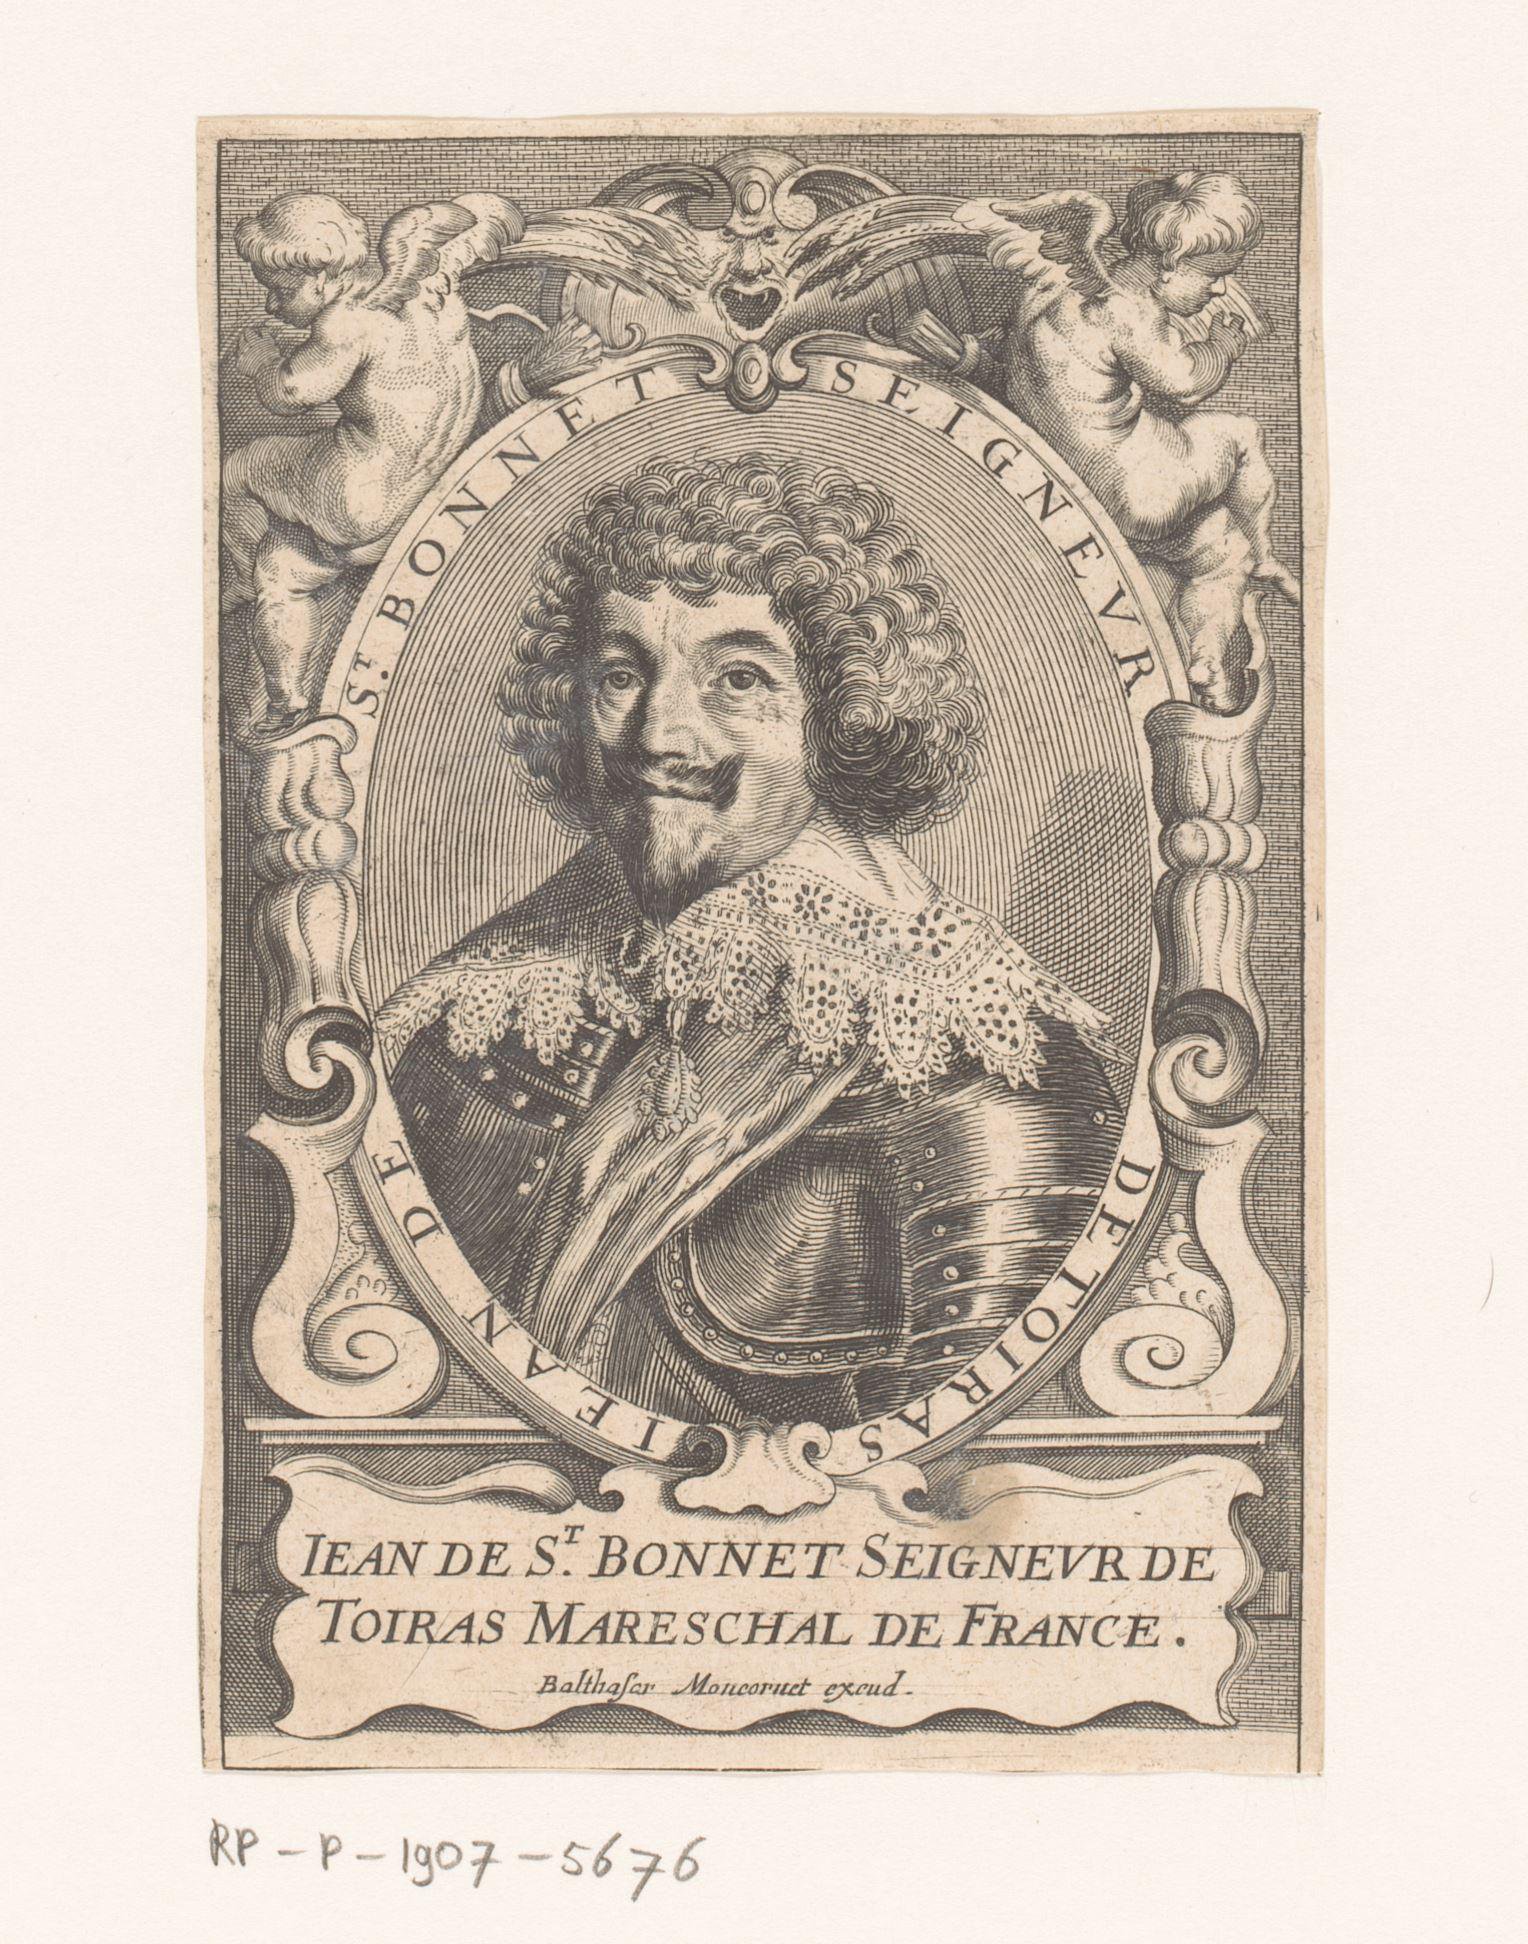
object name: print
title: Portret van Jean Caylar d'Anduze de Saint-Bonnet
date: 1610-1668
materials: paper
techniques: engraving, etching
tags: historical persons, ornament ~ cartouche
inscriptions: collector's mark: Lugt 2228